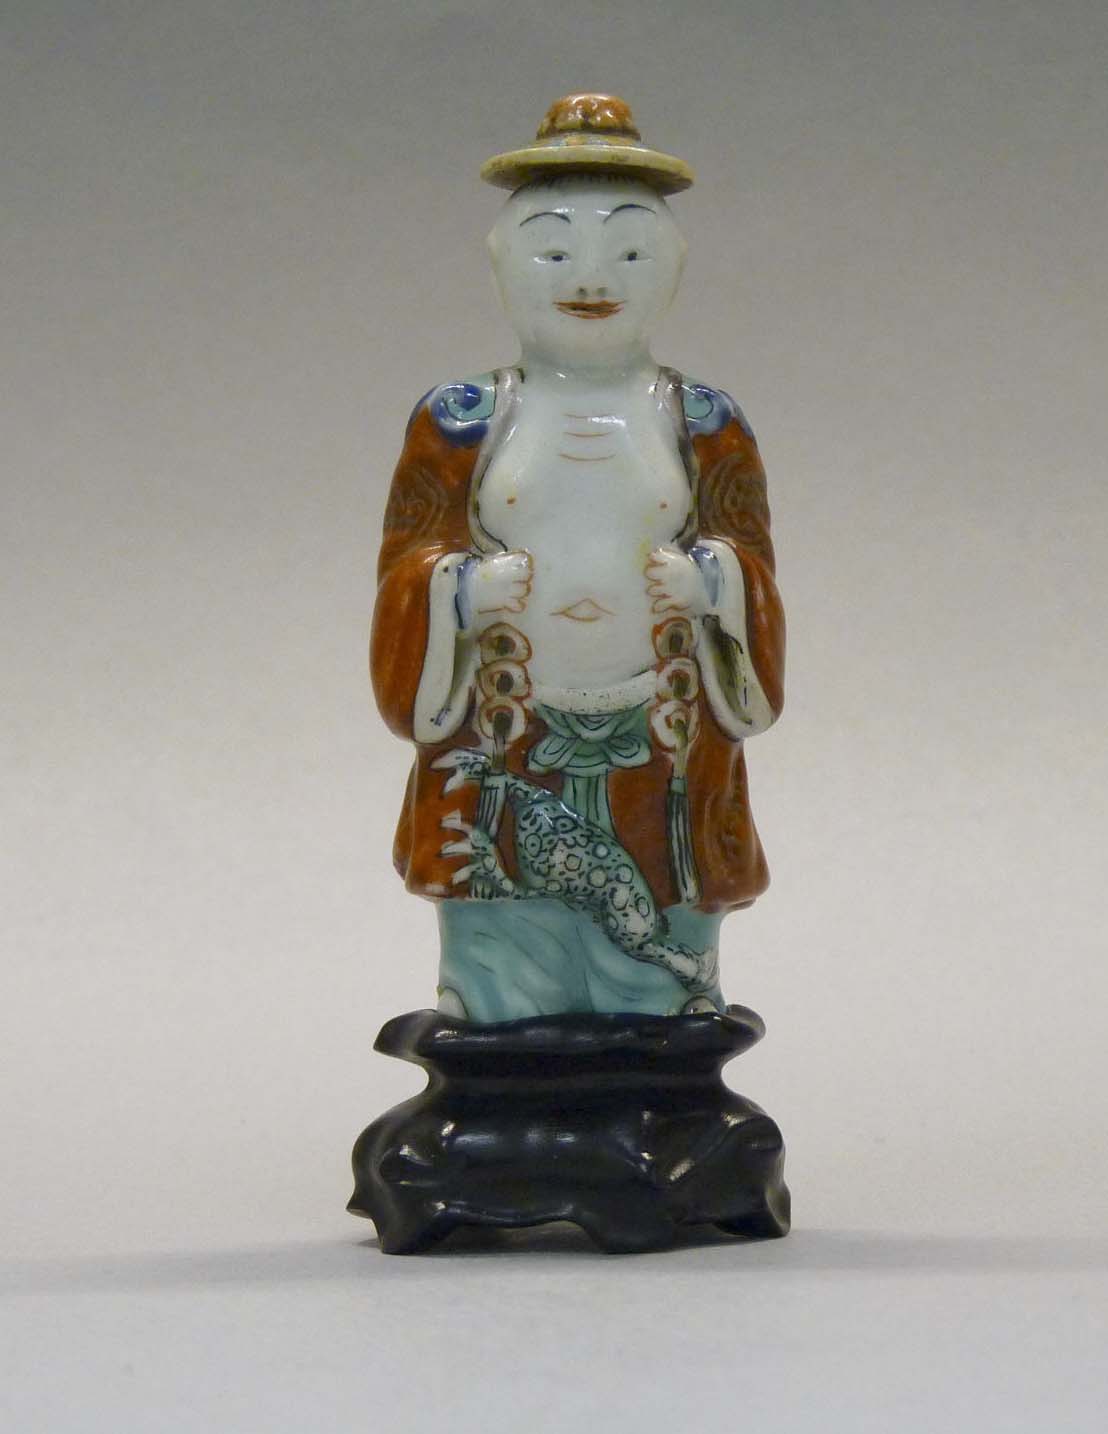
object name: snuff bottle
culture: chinese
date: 1736-1795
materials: porcelain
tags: men